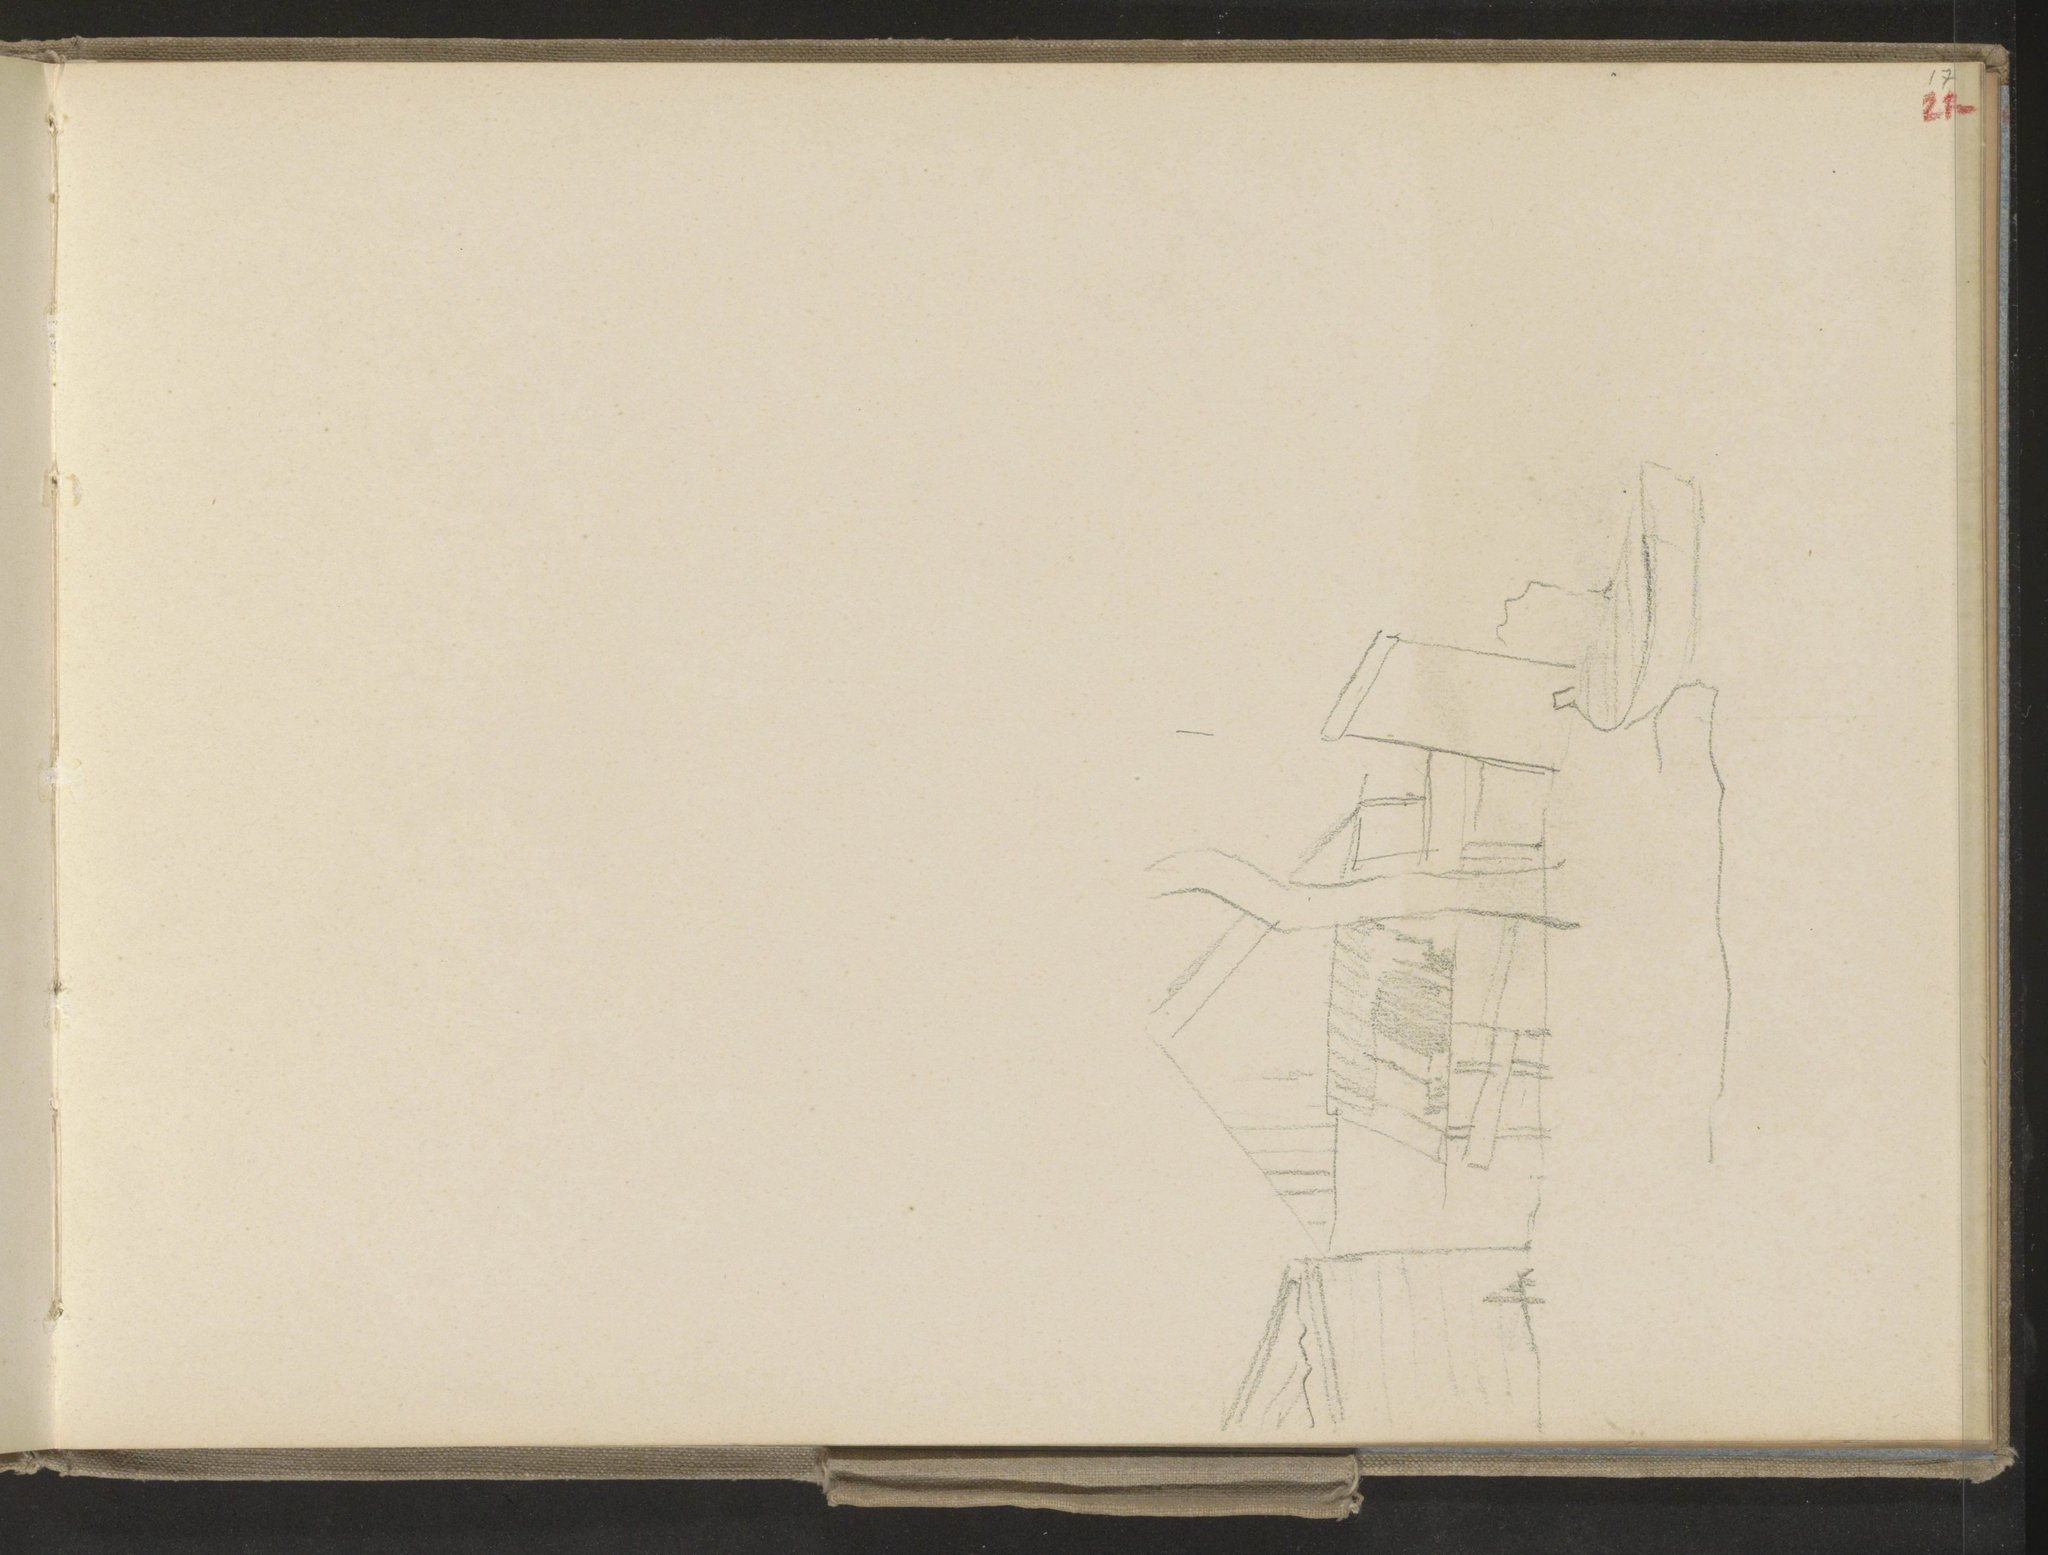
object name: sketchbook leaf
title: Boom en een roeiboot bij een plattelandswoning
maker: jozef israëls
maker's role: draughtsman, painter, print maker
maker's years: 1824-1911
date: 1834-1911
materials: paper, pencil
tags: rowing-boat, canoe, etc., cottage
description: Blad 17 recto uit een schetsboek met 27 bladen.